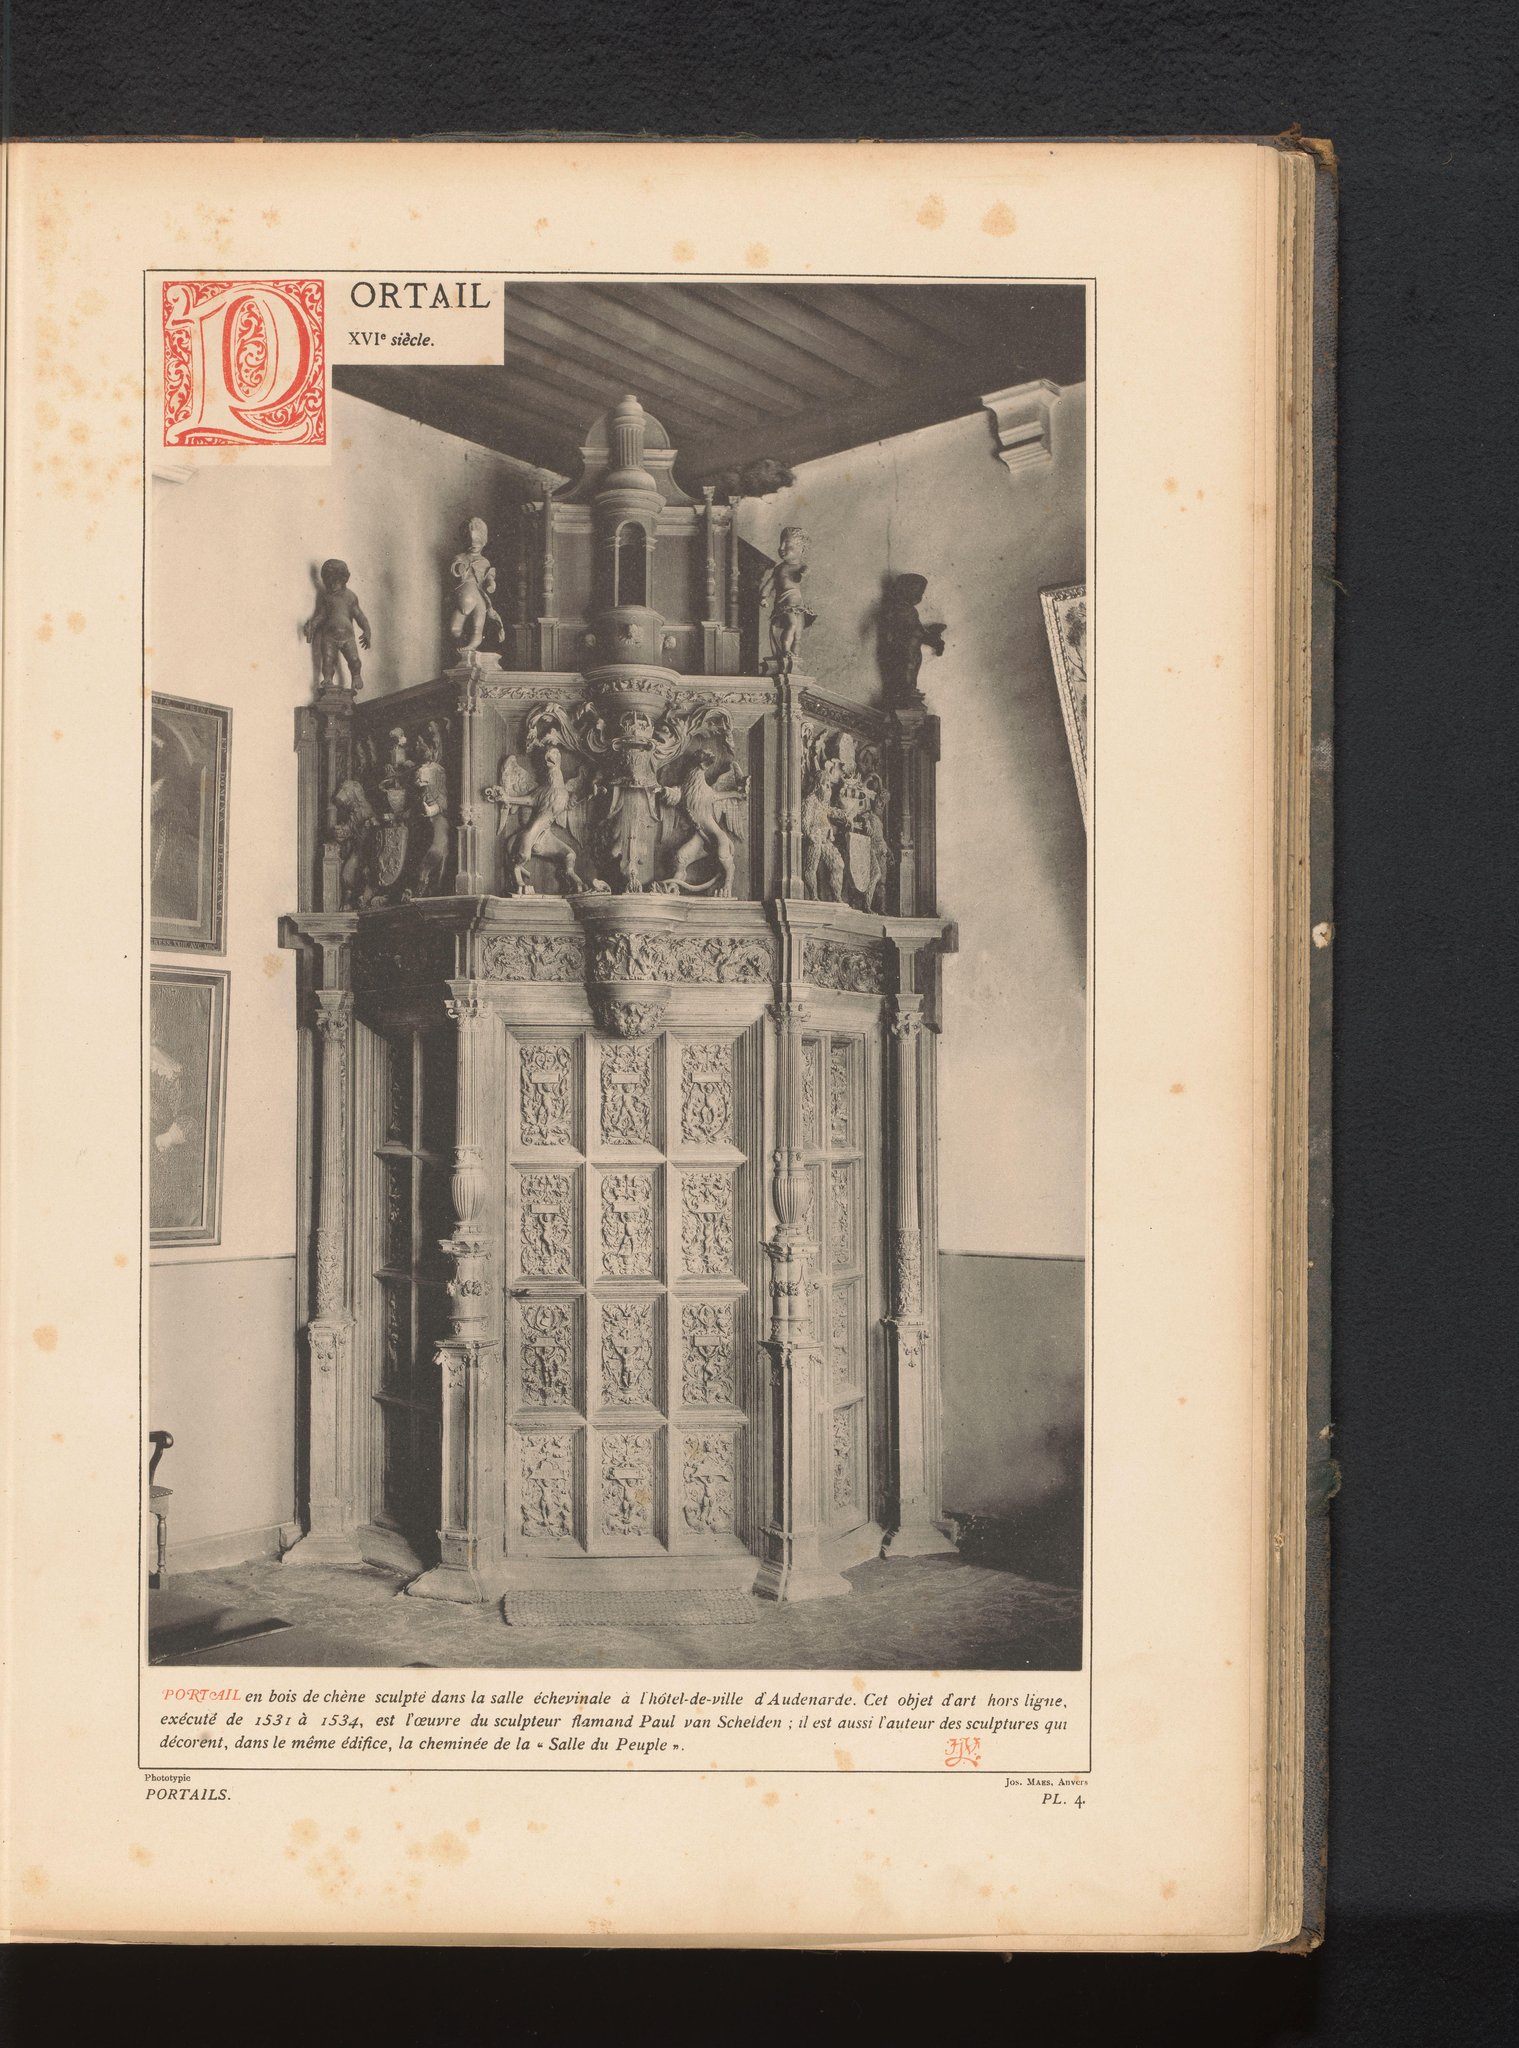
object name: page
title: Gedecoreerde deur van eikenhout in het stadhuis van Oudenaarde, België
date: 1882-1887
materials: paper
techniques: photograph, photolithography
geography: oudenaarde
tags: townhall, closed door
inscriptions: inscription: ‘PORTAILS. - PL. 4.’, monogram: ‘JJvY’, inscription: ‘PORTAIL en bois (...)’